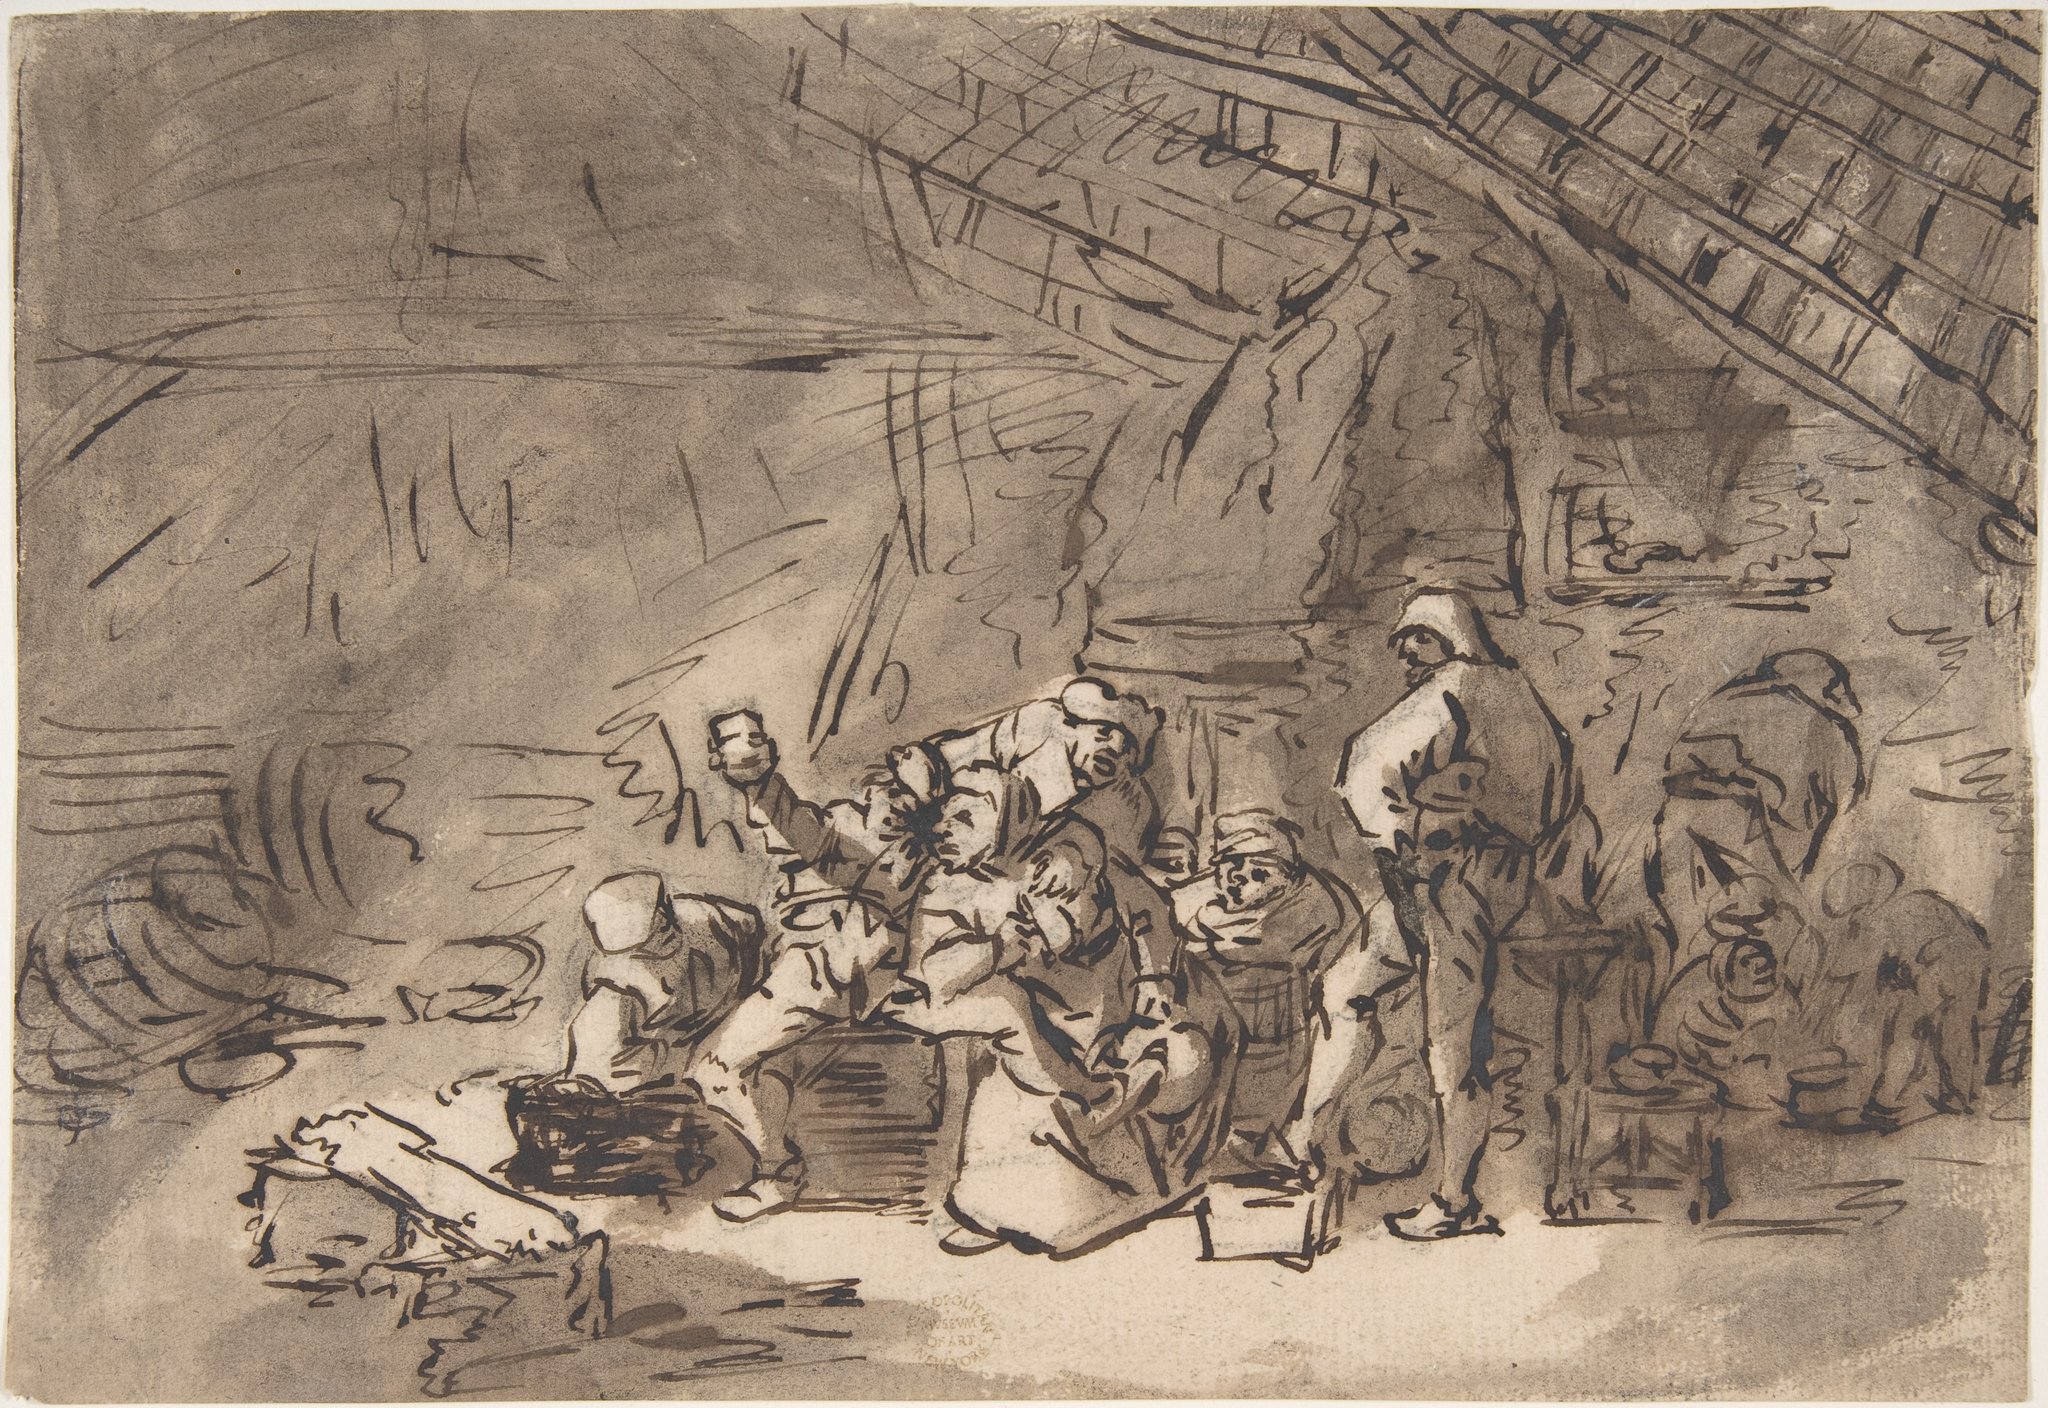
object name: drawing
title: Scene in an Inn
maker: adriaen van ostade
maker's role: artist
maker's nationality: dutch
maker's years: 1610-1685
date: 1625-1685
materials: chalk, ink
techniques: brush, pen, wash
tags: human figures,inns